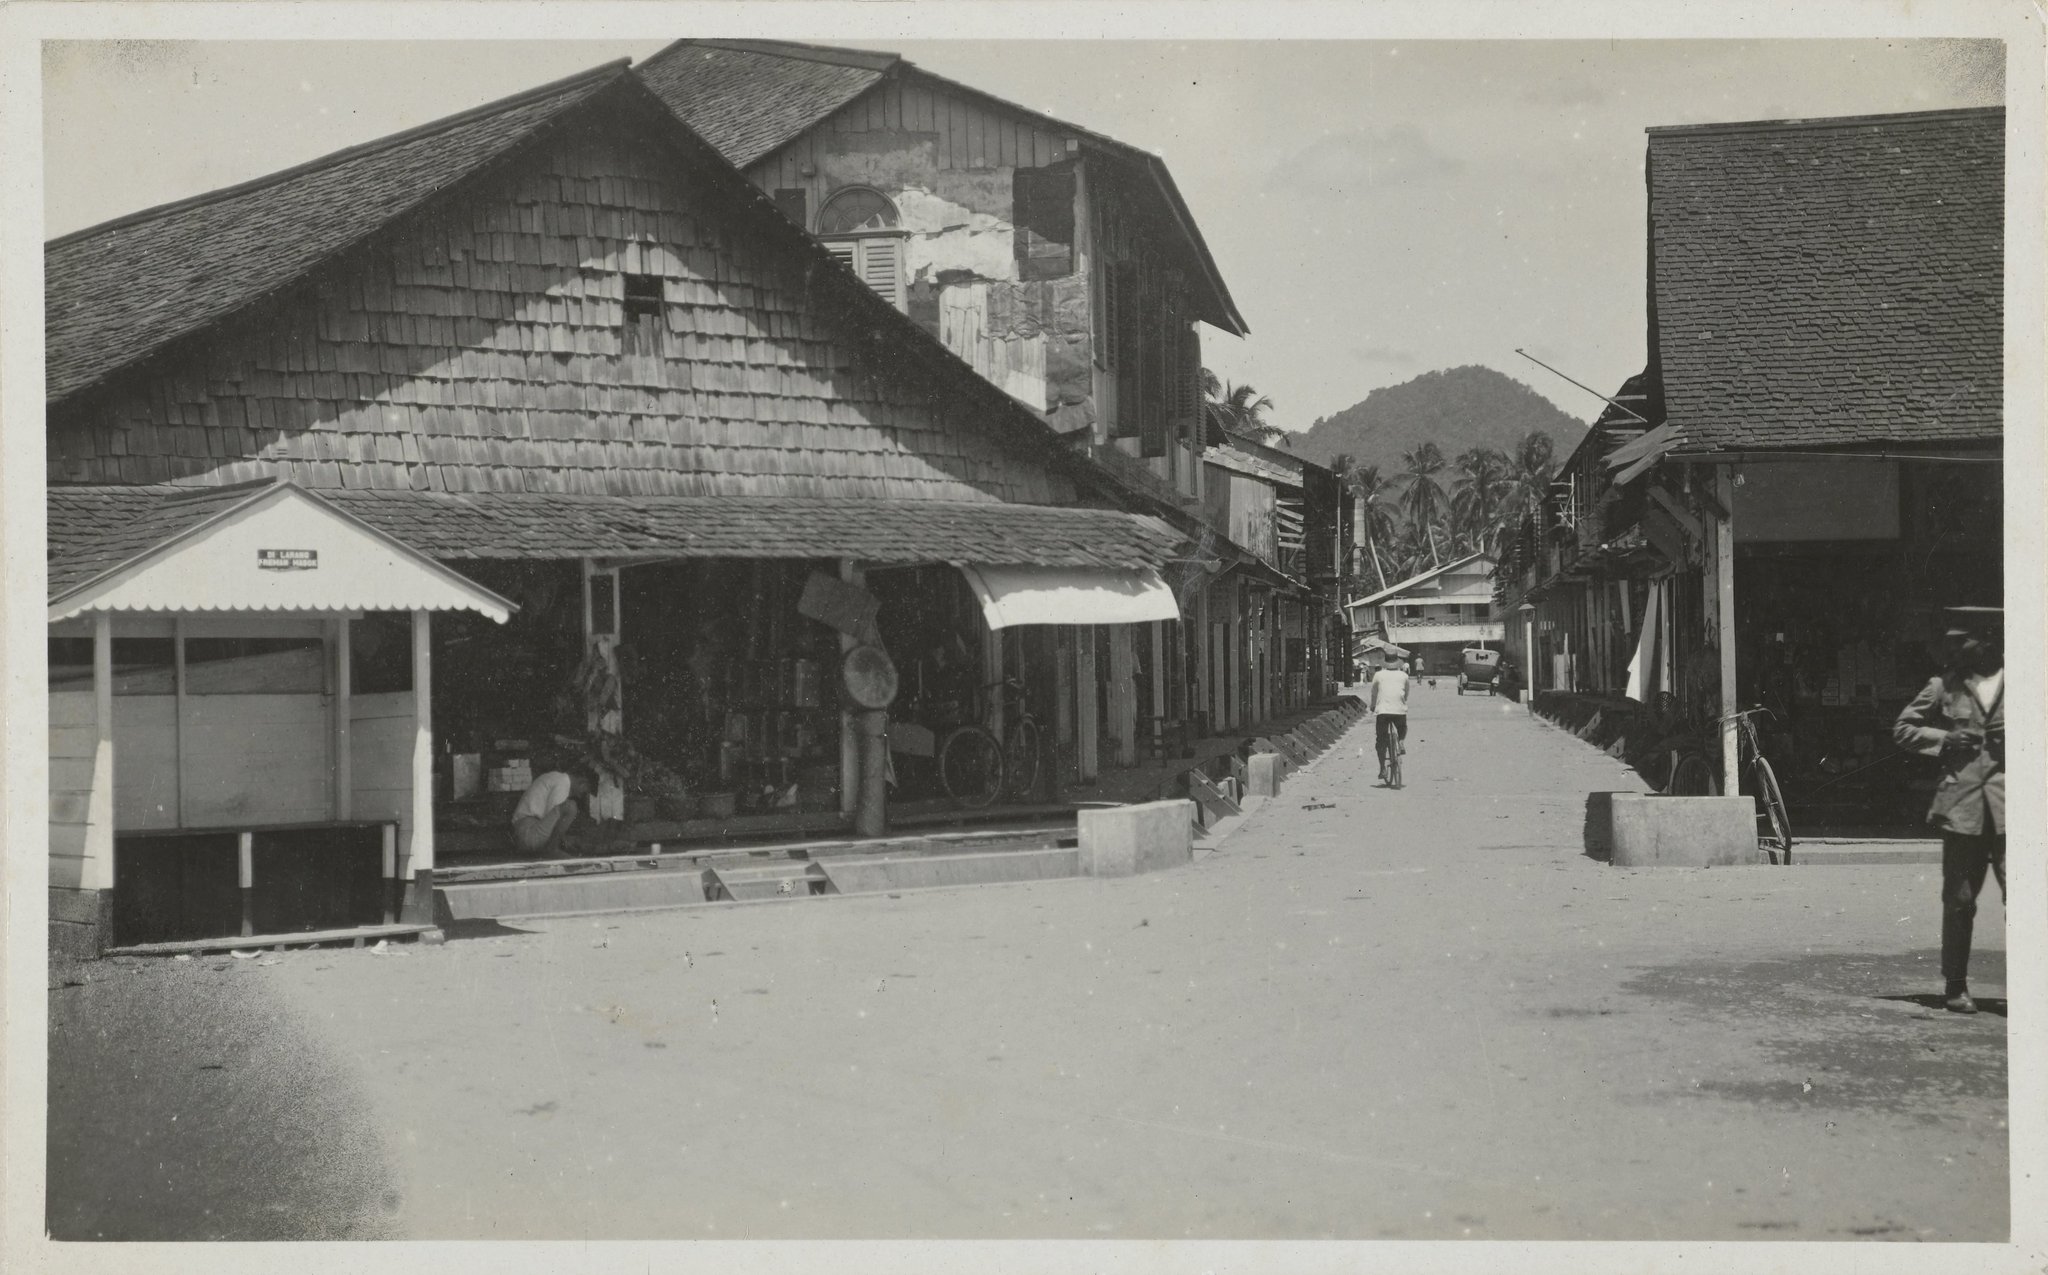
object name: photograph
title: Straatgezicht met winkels in Singkawang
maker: Anonymous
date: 1920-1940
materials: photographic support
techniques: gelatin silver print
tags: borneo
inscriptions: annotation: ‘Post card, correspondence address only’